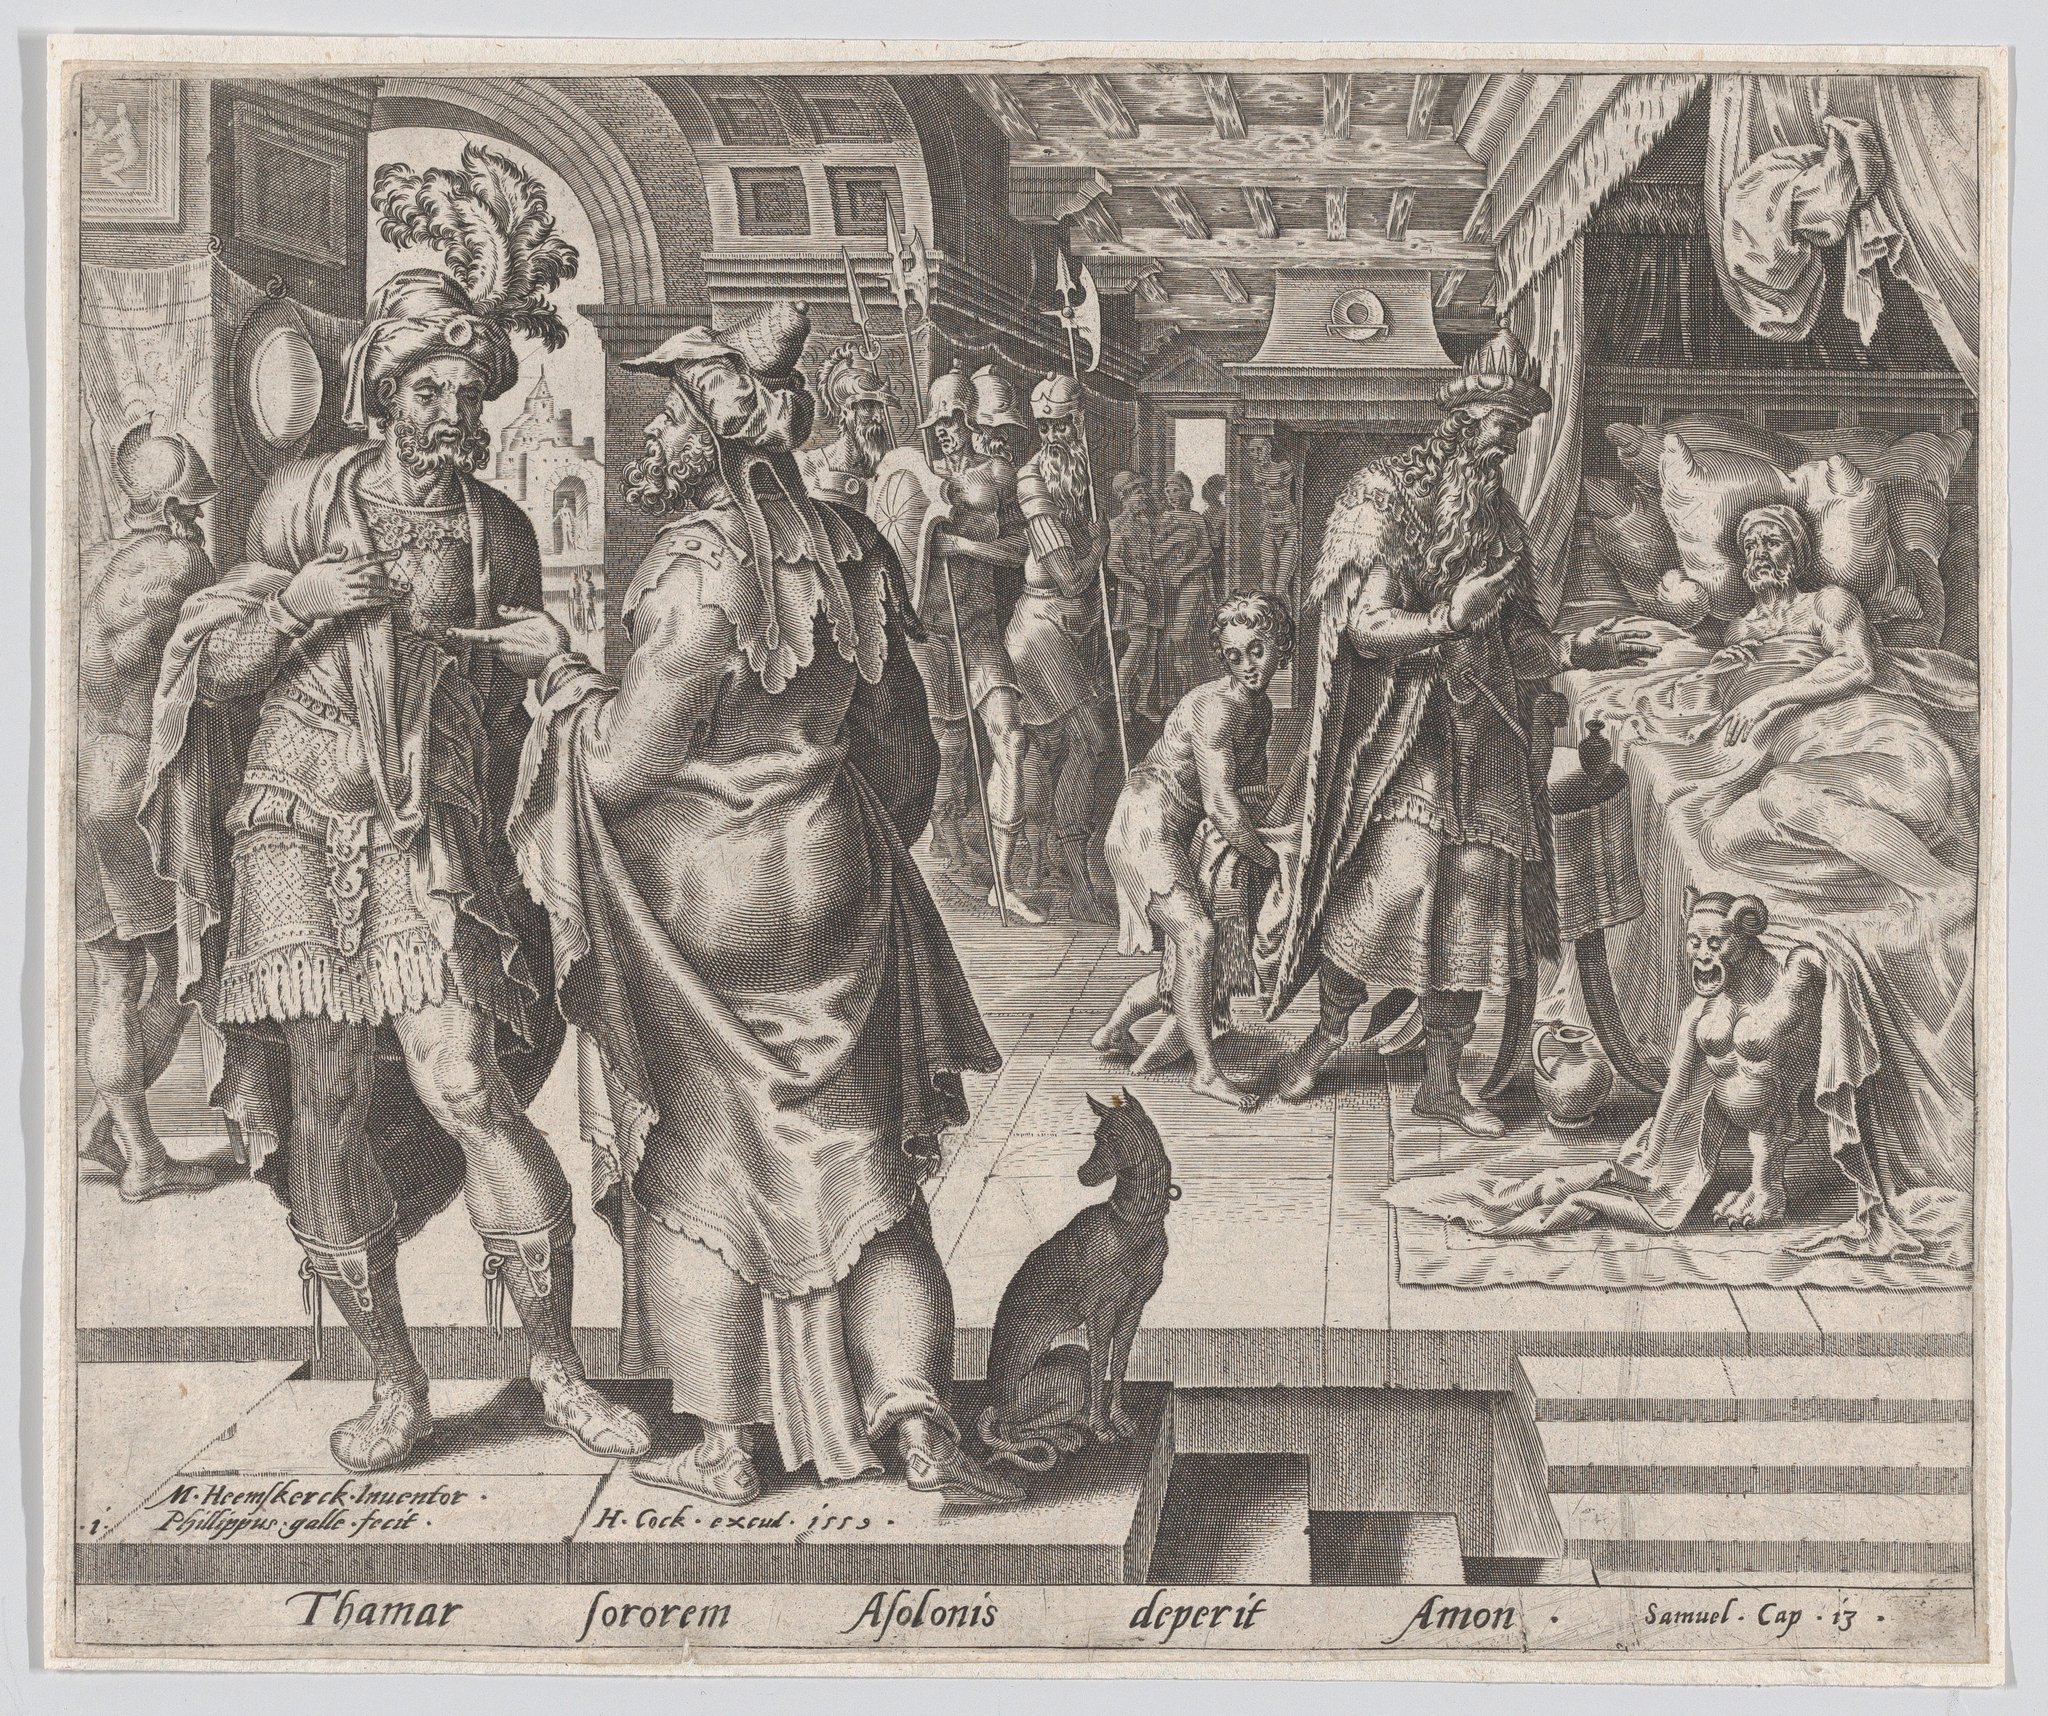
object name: print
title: Jonadab Counselling Amnon, plate 1 from "The Story of Tamar and Amnon"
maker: philips galle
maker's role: artist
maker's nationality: netherlandish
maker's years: 1537-1612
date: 1559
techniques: engraving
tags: soldiers,men,dogs